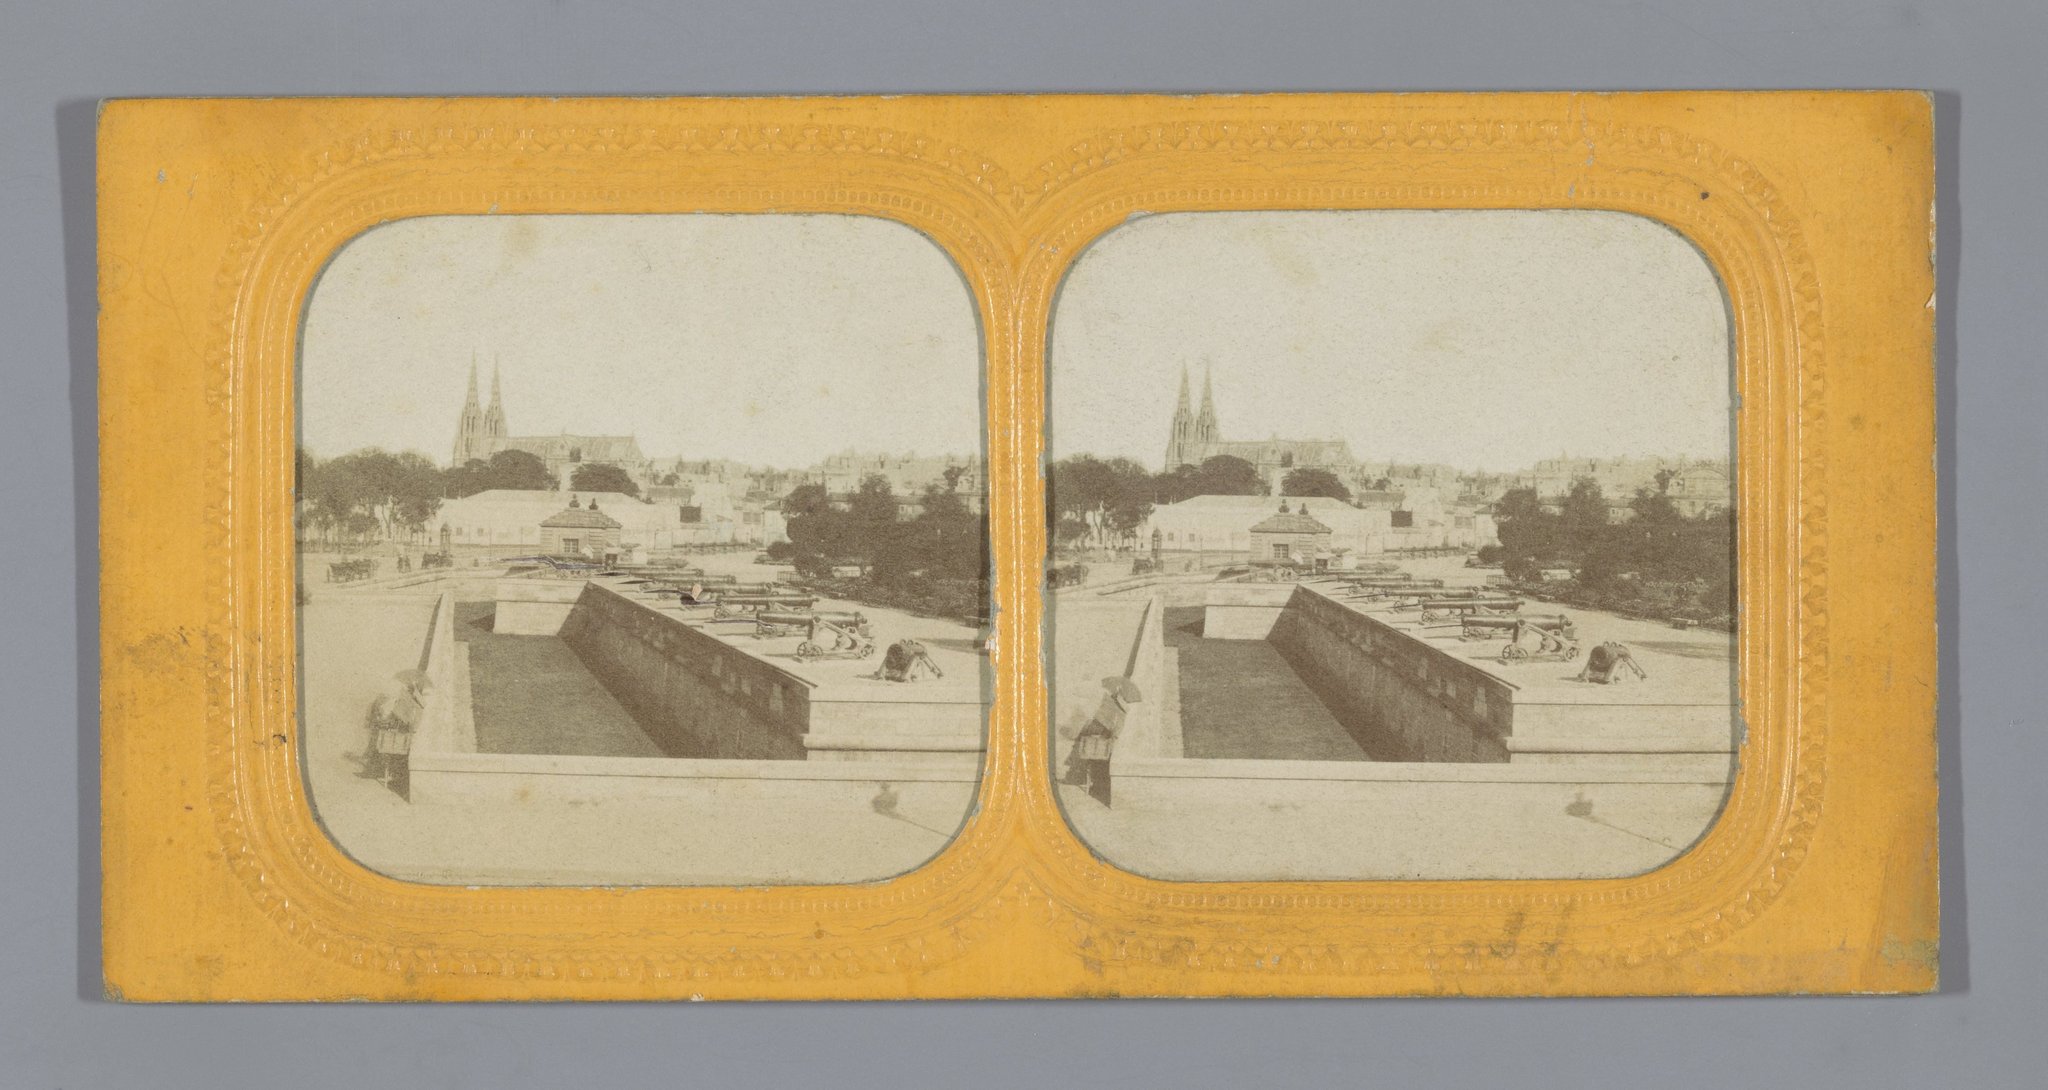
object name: tissue stereograph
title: Connons des Invalides / Les Invalides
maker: Anonymous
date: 1855-1875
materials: cardboard, paper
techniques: albumen print, cutting, hand coloring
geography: paris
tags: firearms: cannon